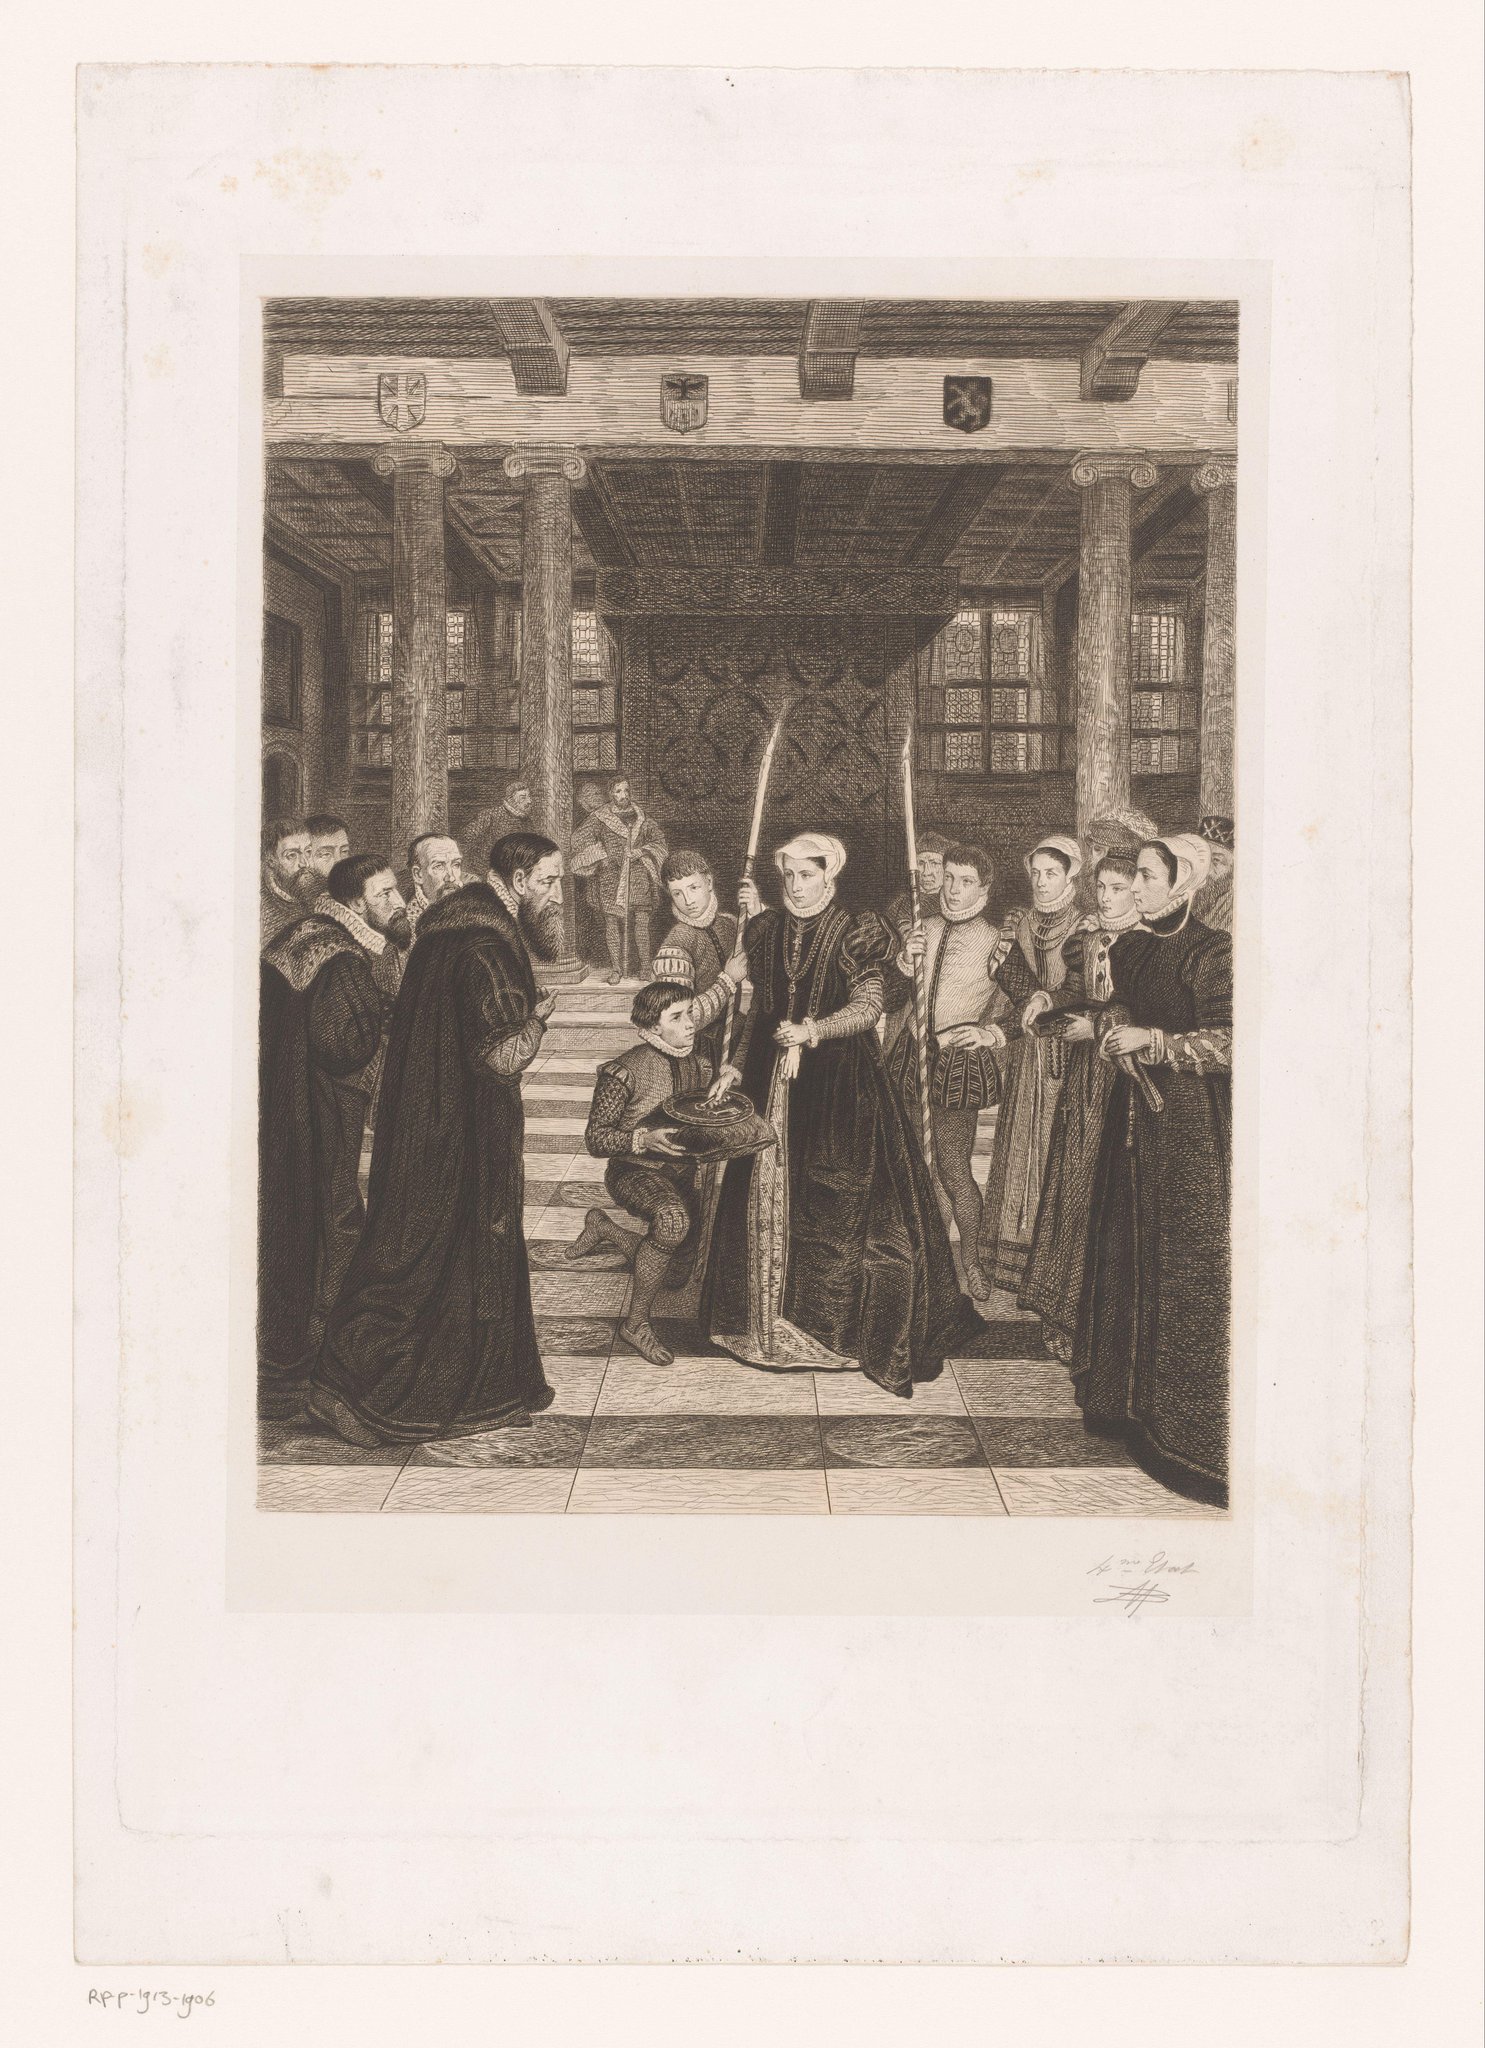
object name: print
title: Margaretha van Parma overhandigt de stadssleutels aan de Antwerpse magistraat in het stadhuis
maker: jean baptiste pierre michiels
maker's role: print maker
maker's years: 1821-1890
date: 1863-1890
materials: paper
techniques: etching, intaglio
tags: key, townhall, interior ~ representation of a building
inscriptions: inscription: ‘4me Etat’, collector's mark: Lugt 2228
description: De prent is gemaakt naar de muurschilderingen van Henri Leys in het Stadhuis van Antwerpen. Prent is verschenen in: Leys, Henri. De Zaal Leys op het Stadhuis van Antwerpen: zeven kopersneden naar de muurschilderingen van Baron H. Leys. Antwerpen: Museum Plantin-Moretus, 1902.